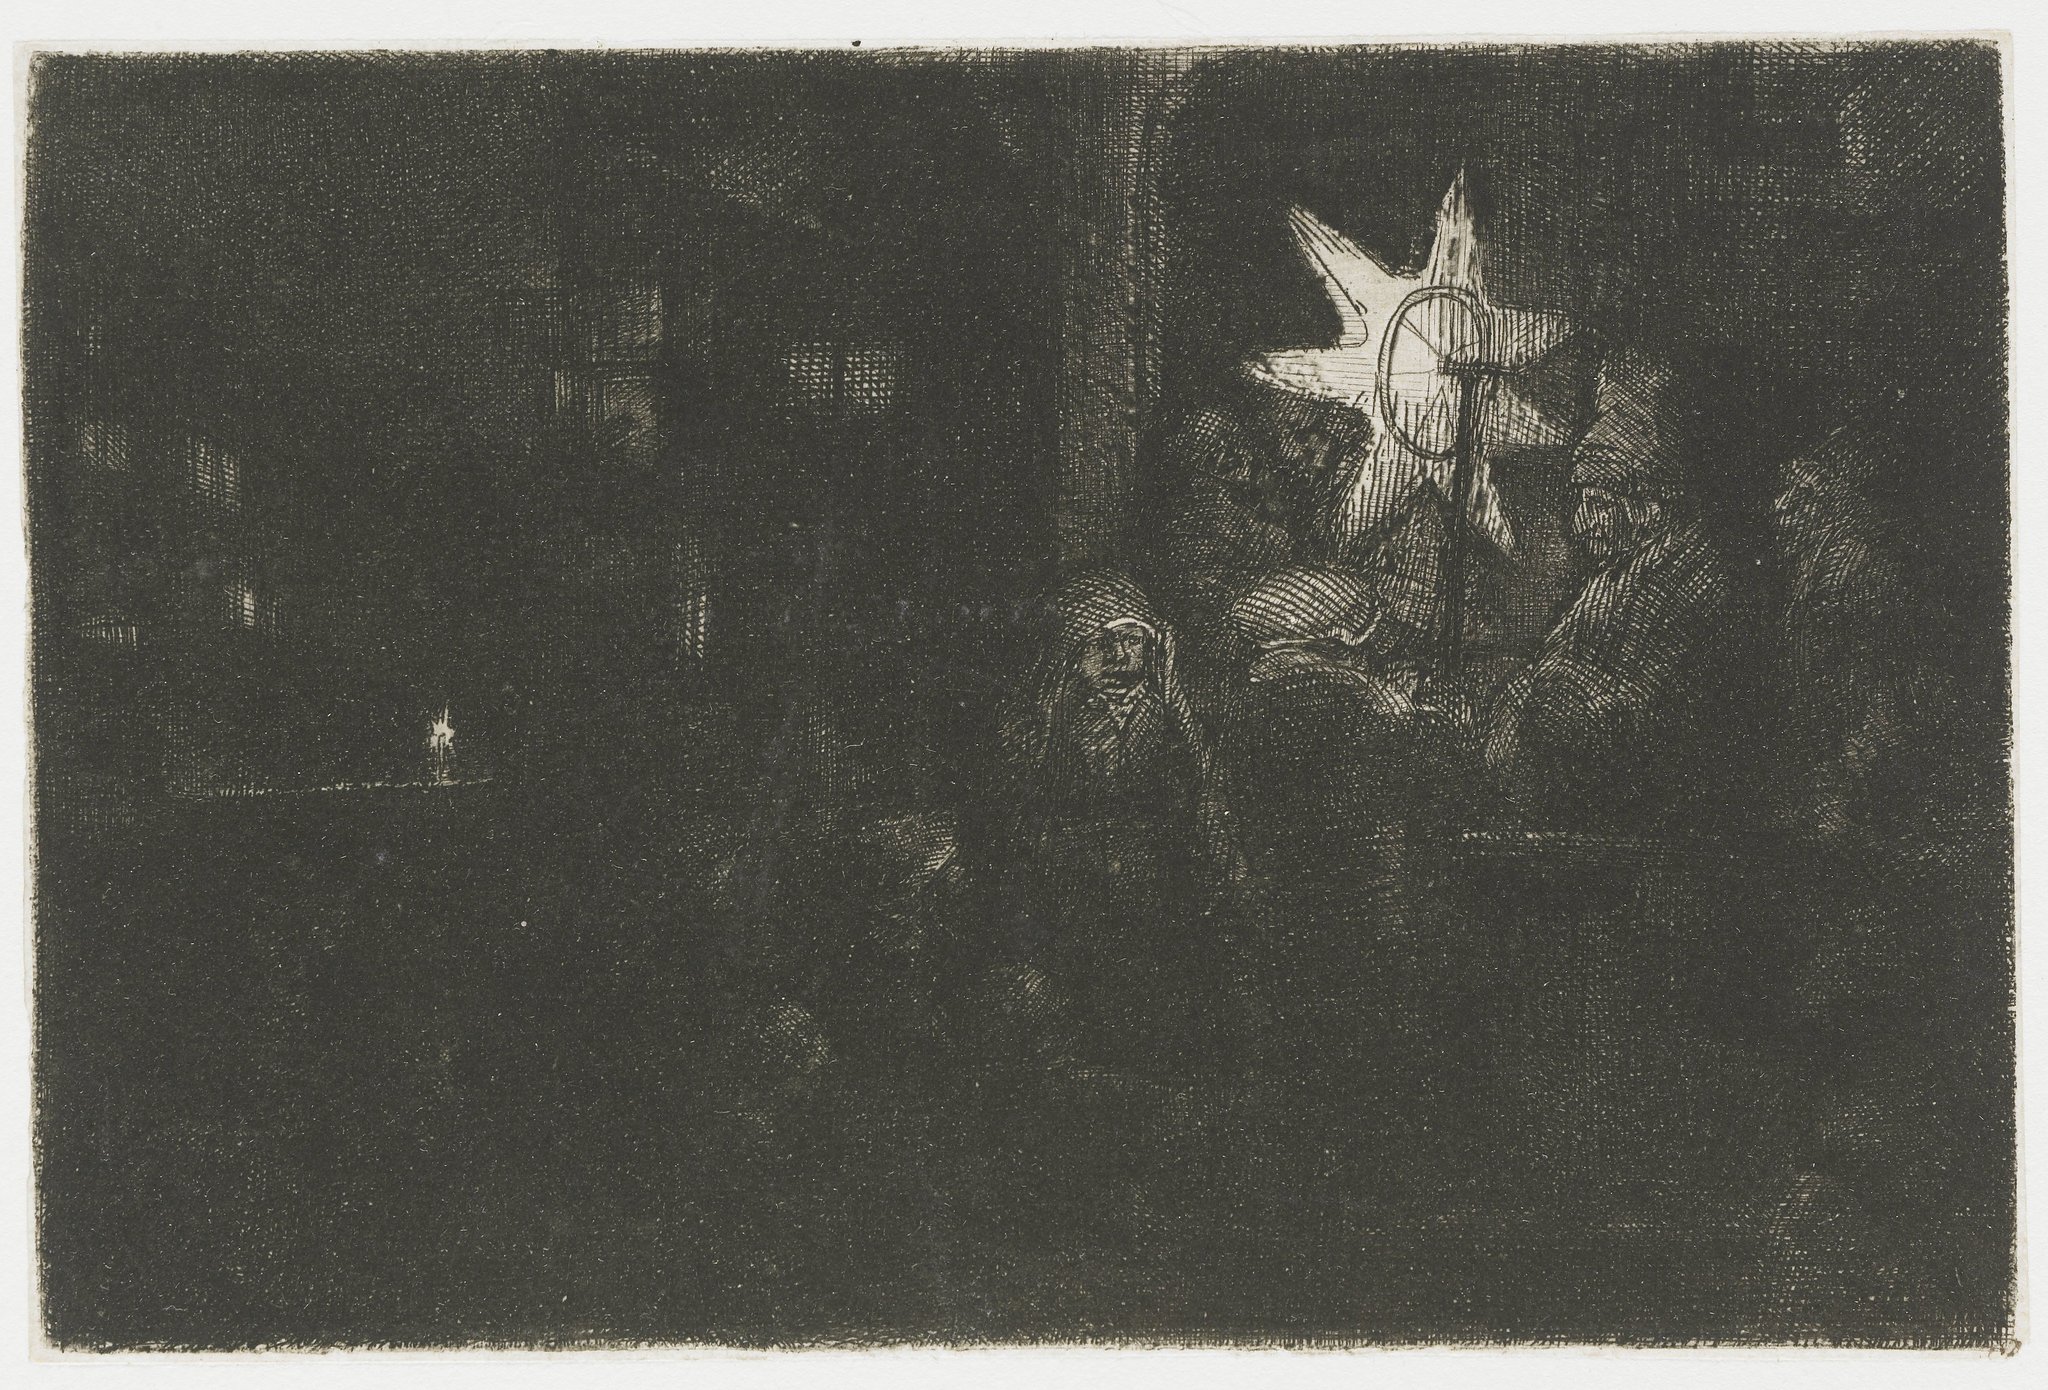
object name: print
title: The Star of the Kings: a night piece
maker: rembrandt van rijn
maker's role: draughtsman, painter, print maker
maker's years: 1606-1669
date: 1651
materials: paper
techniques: drypoint, etching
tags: twelfth night, usually falling on the eve of january 6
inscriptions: mark: Lugt 514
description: Driekoningen: een nachtstuk. Een groep kinderen met een verlichte ster bij een oude man op Driekoningenavond.